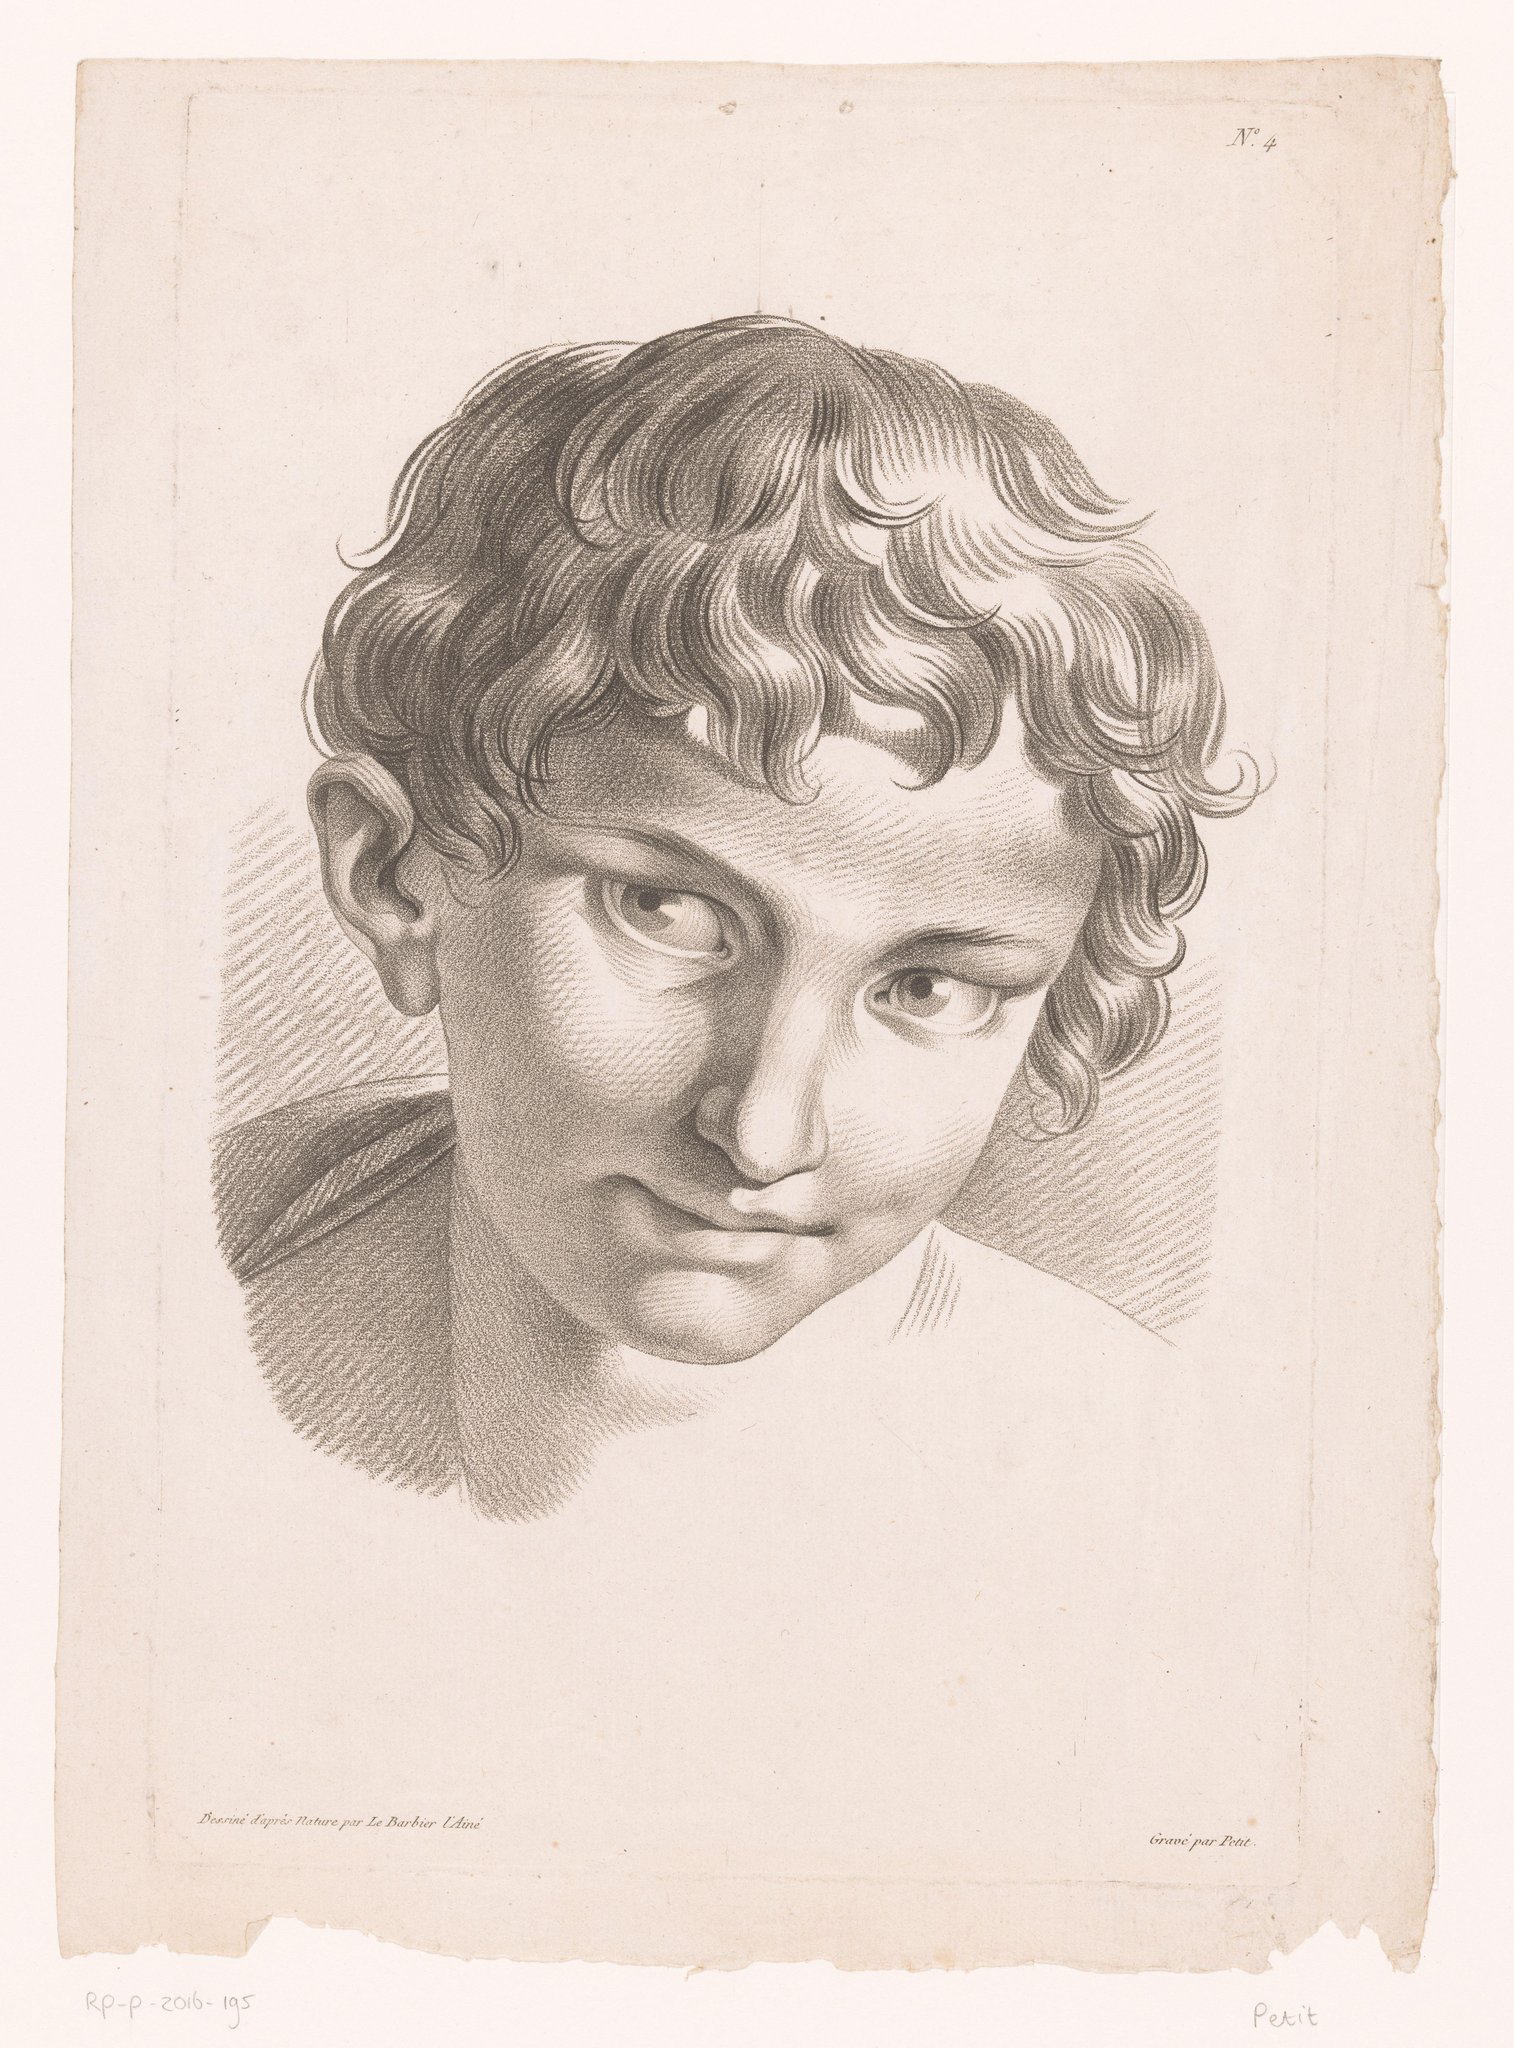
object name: print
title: Principes van het tekenen naar de natuur, deel vier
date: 1784-1826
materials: paper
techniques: printmaking, etching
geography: paris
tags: drawing, sketch, head (human)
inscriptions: collector's mark: Lugt 2228